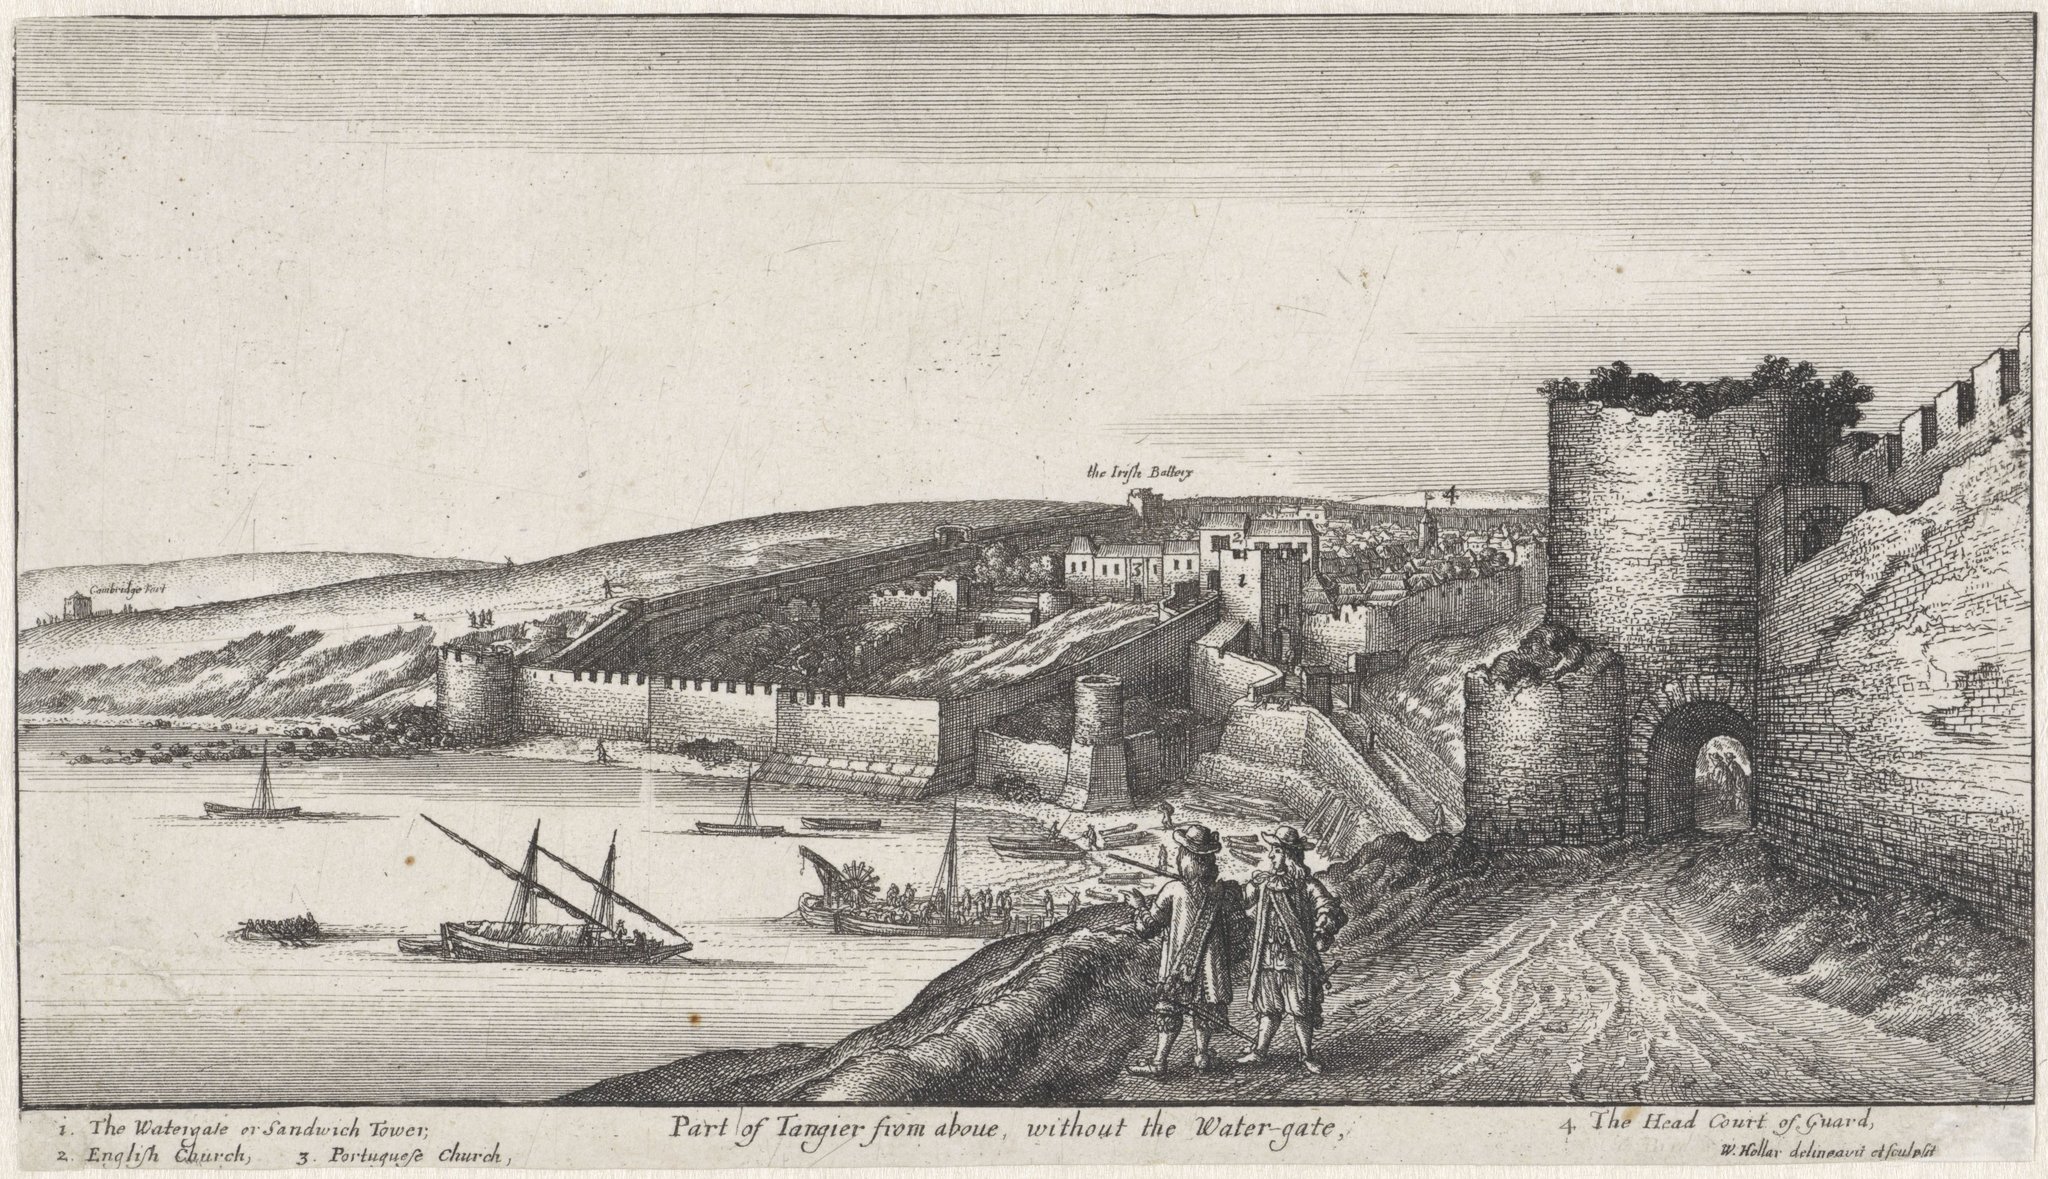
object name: print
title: Gezichten op Tanger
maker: wenceslaus hollar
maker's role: draughtsman, print maker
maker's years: 1607-1677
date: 1669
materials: paper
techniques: etching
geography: london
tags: city-view, and landscape with man-made constructions, coast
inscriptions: collector's mark: Lugt 2228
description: De prent maakt deel uit van een zesdelige serie (inclusief titelprent) met gezichten op Tanger (ongenummerd).